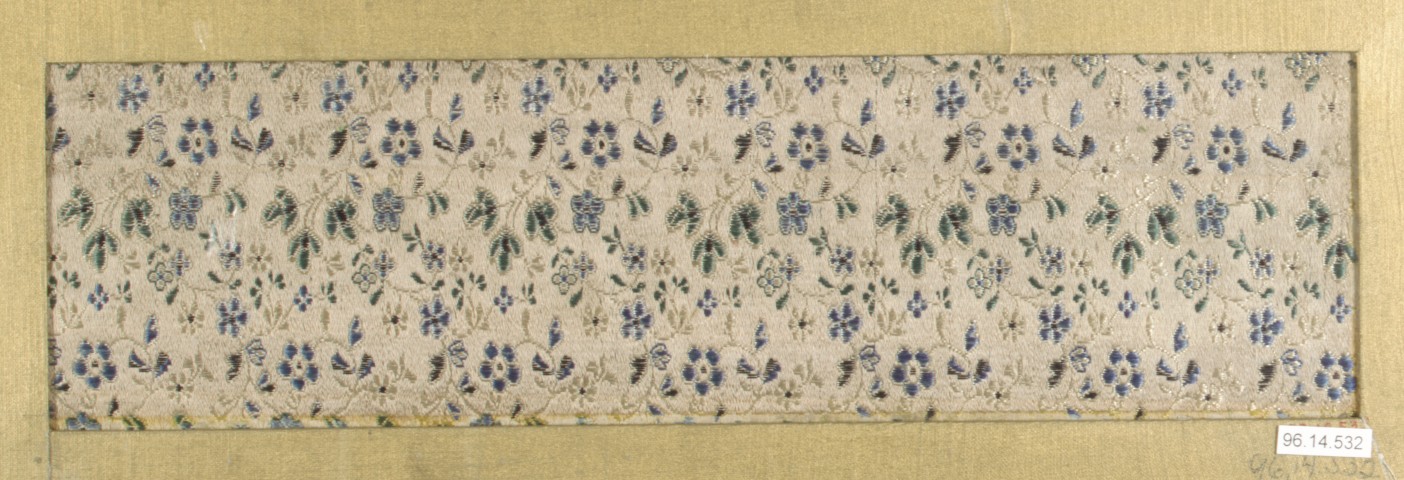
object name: piece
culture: japanese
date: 1701-1900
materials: silk